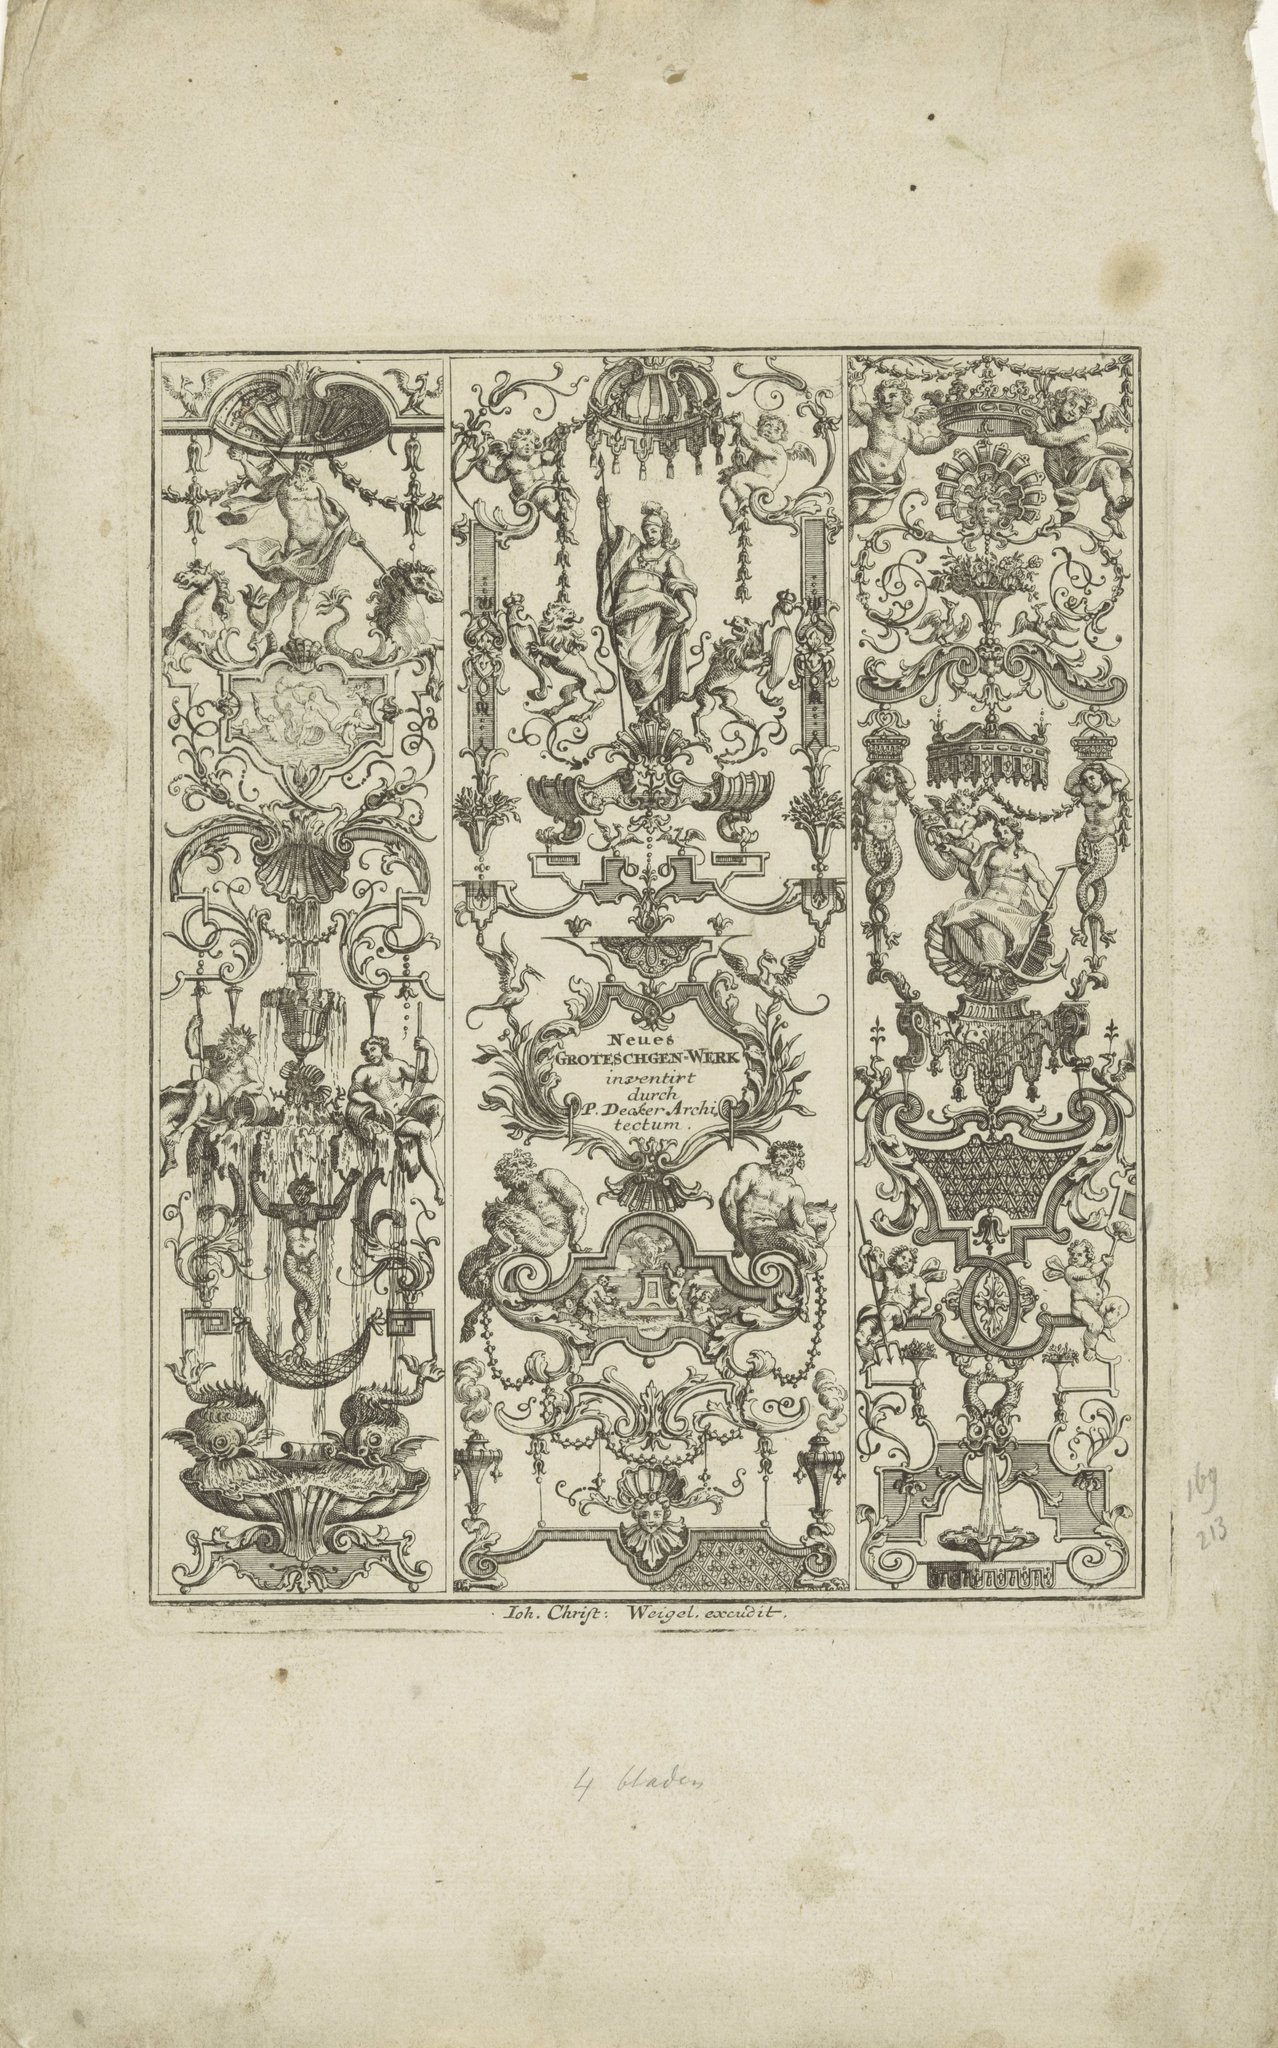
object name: ornament print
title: Neues Groteschgen-Werk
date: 1700-1725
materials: paper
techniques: etching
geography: nuremberg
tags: ornament ~ grotesque, (story of) minerva (pallas, athena), neptune as lord of the sea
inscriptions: collector's mark: Lugt 2228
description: Drie pilasters met grotesken en diverse mythische figuren en scènes.